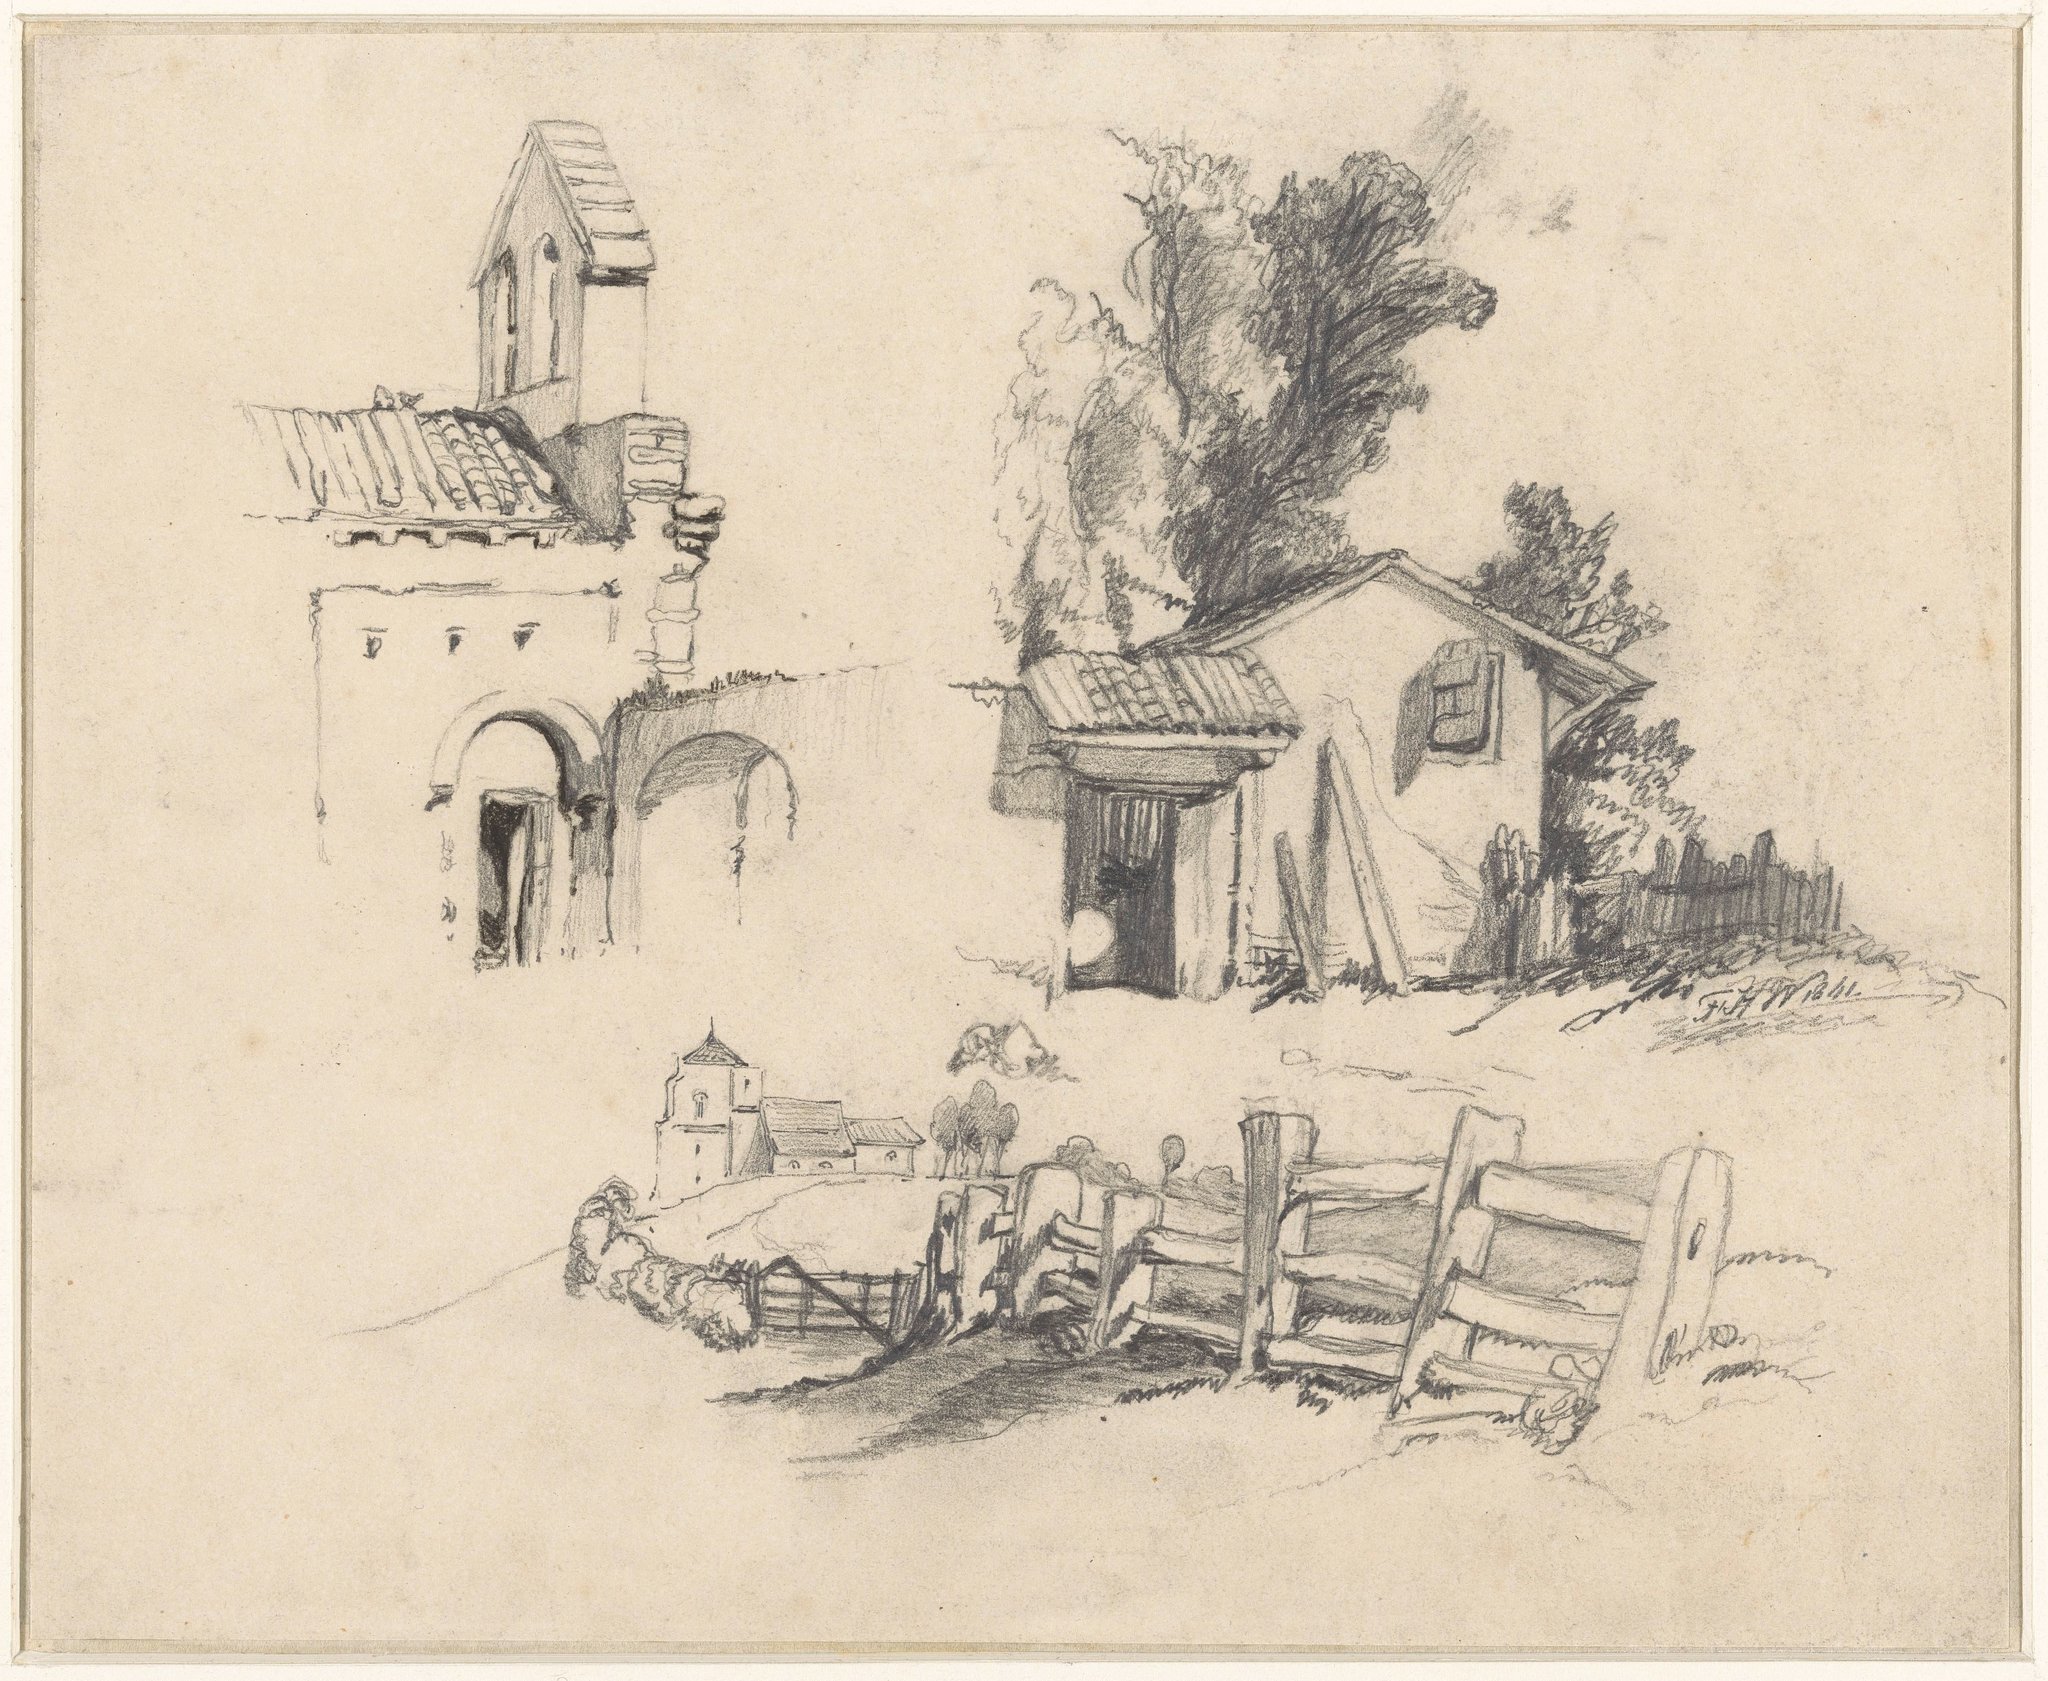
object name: drawing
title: Drie studies van een kerk, huisje en hek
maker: frederik hendrik weissenbruch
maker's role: draughtsman, print maker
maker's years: 1828-1887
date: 1841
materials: paper, pencil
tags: rural housing, e.g. country-house, villa, cottage, church (exterior)